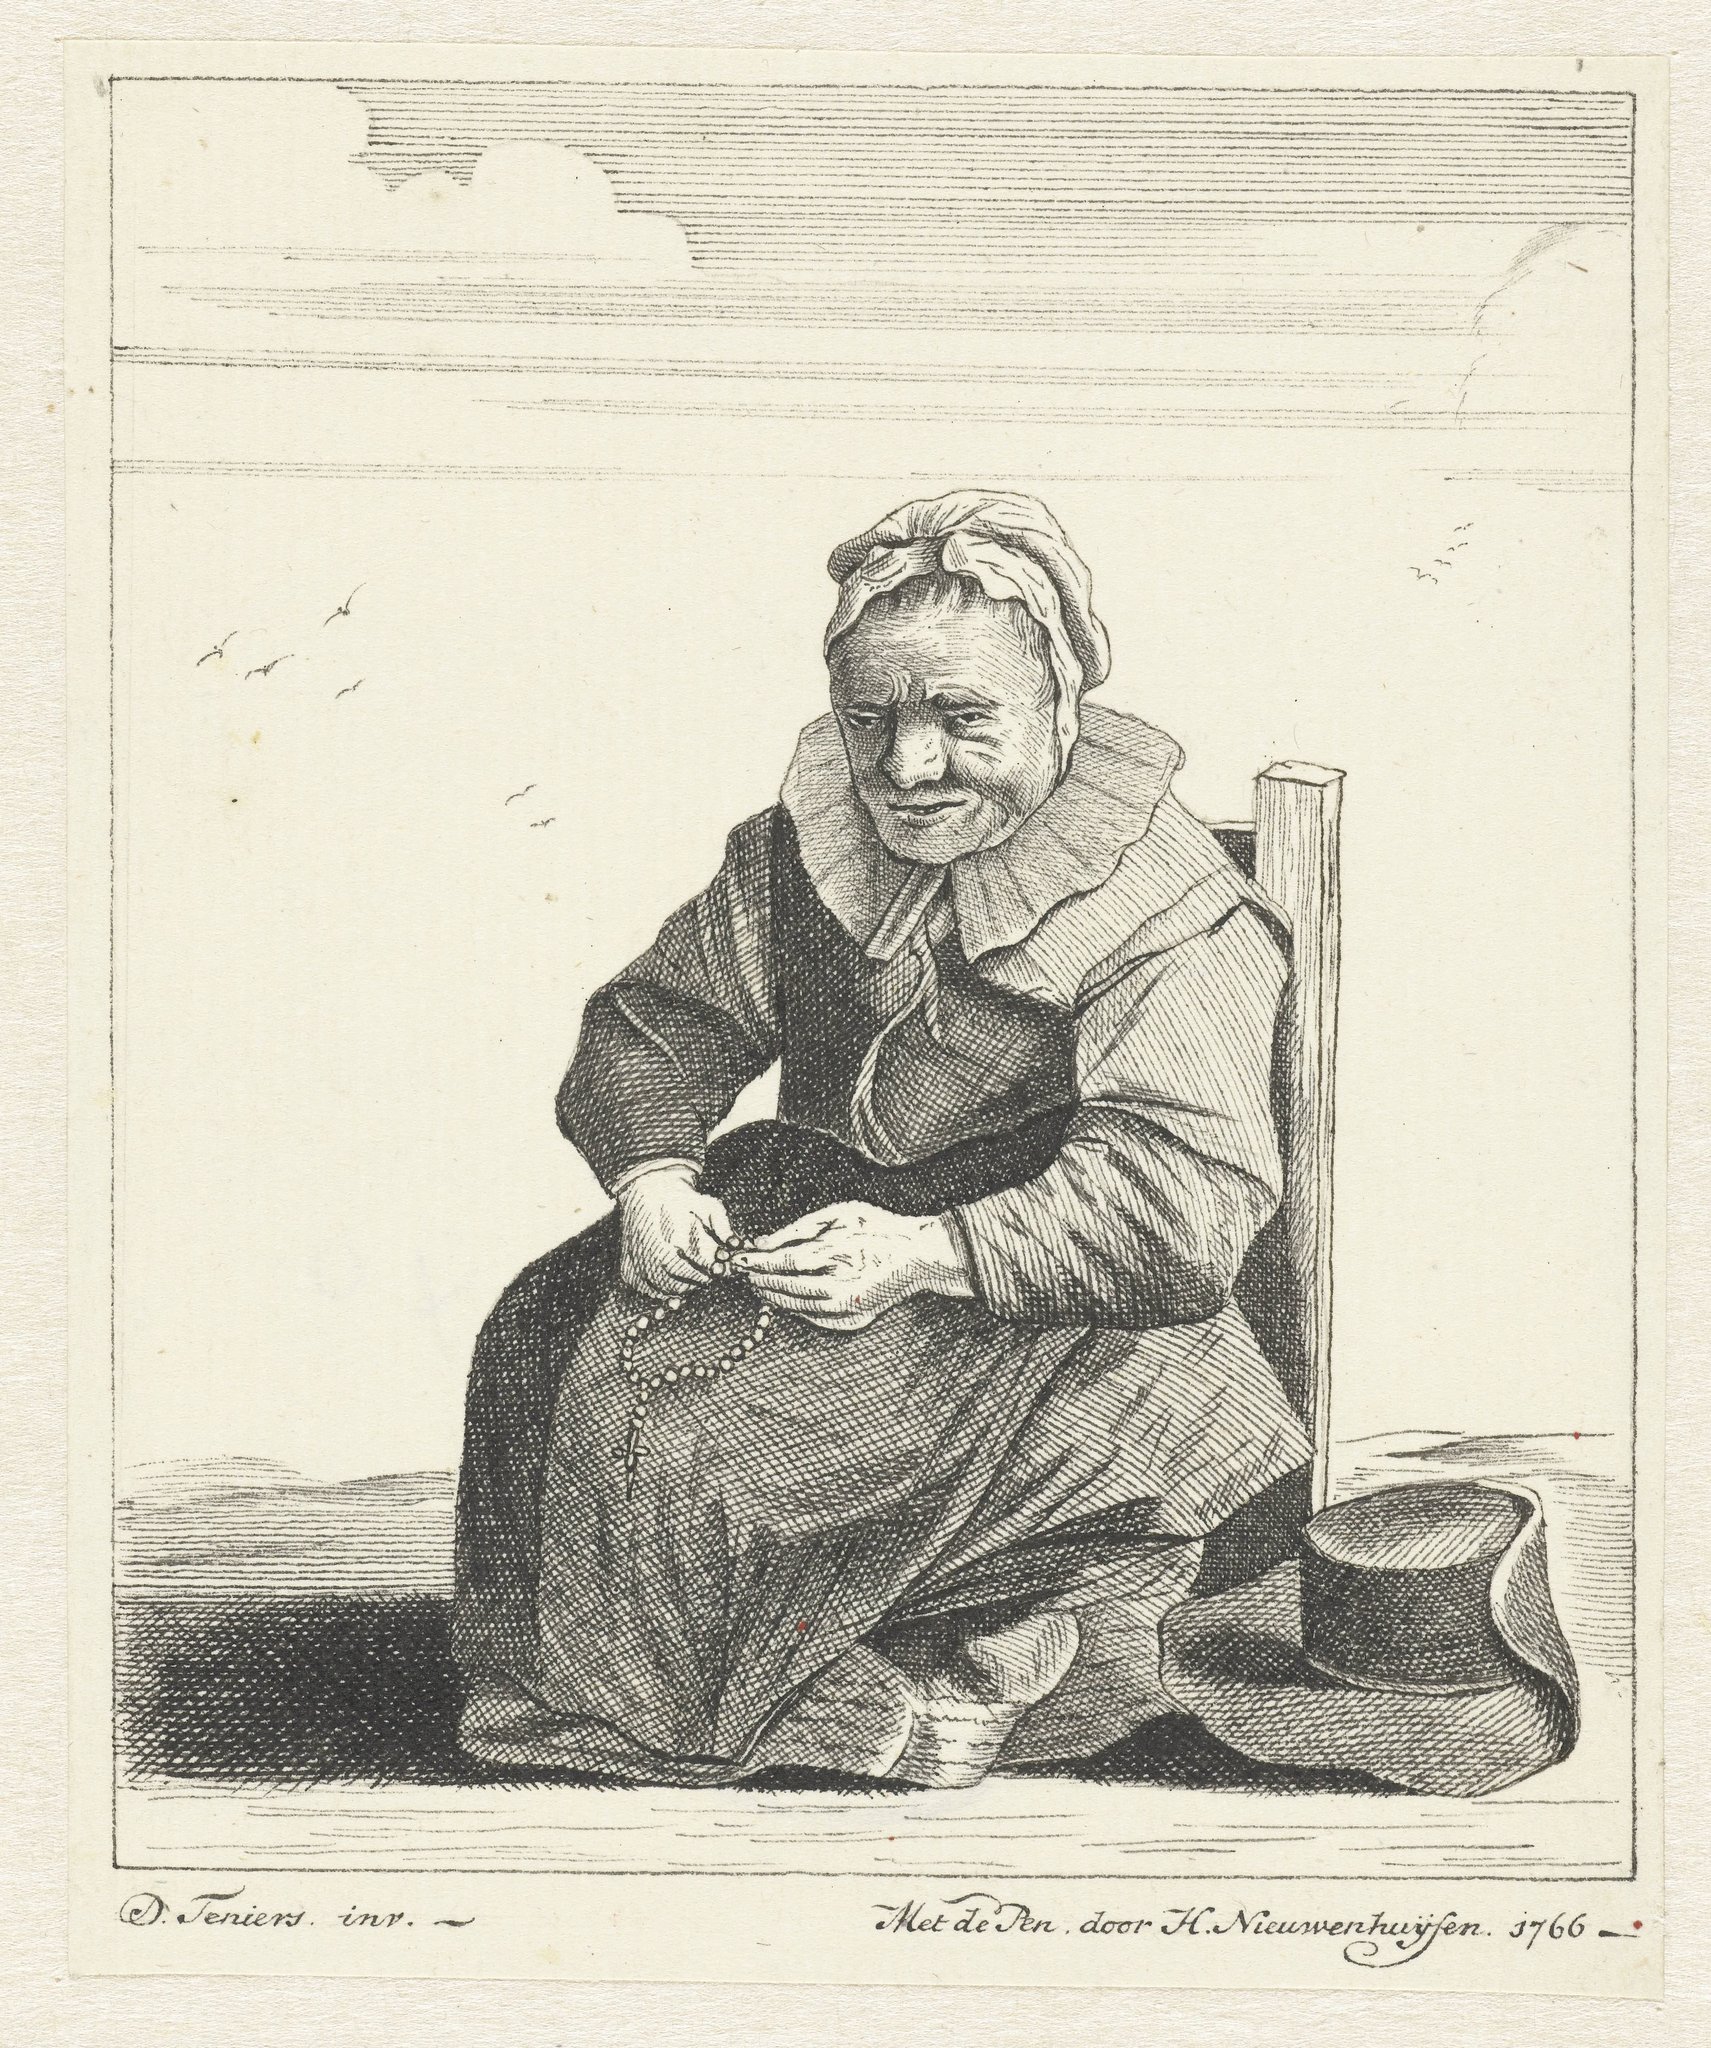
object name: drawing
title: Zittende oude vrouw met rozenkrans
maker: hendrik nieuwenhuysen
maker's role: draughtsman, print maker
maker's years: 1747-1794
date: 1766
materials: ink, paper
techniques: pen